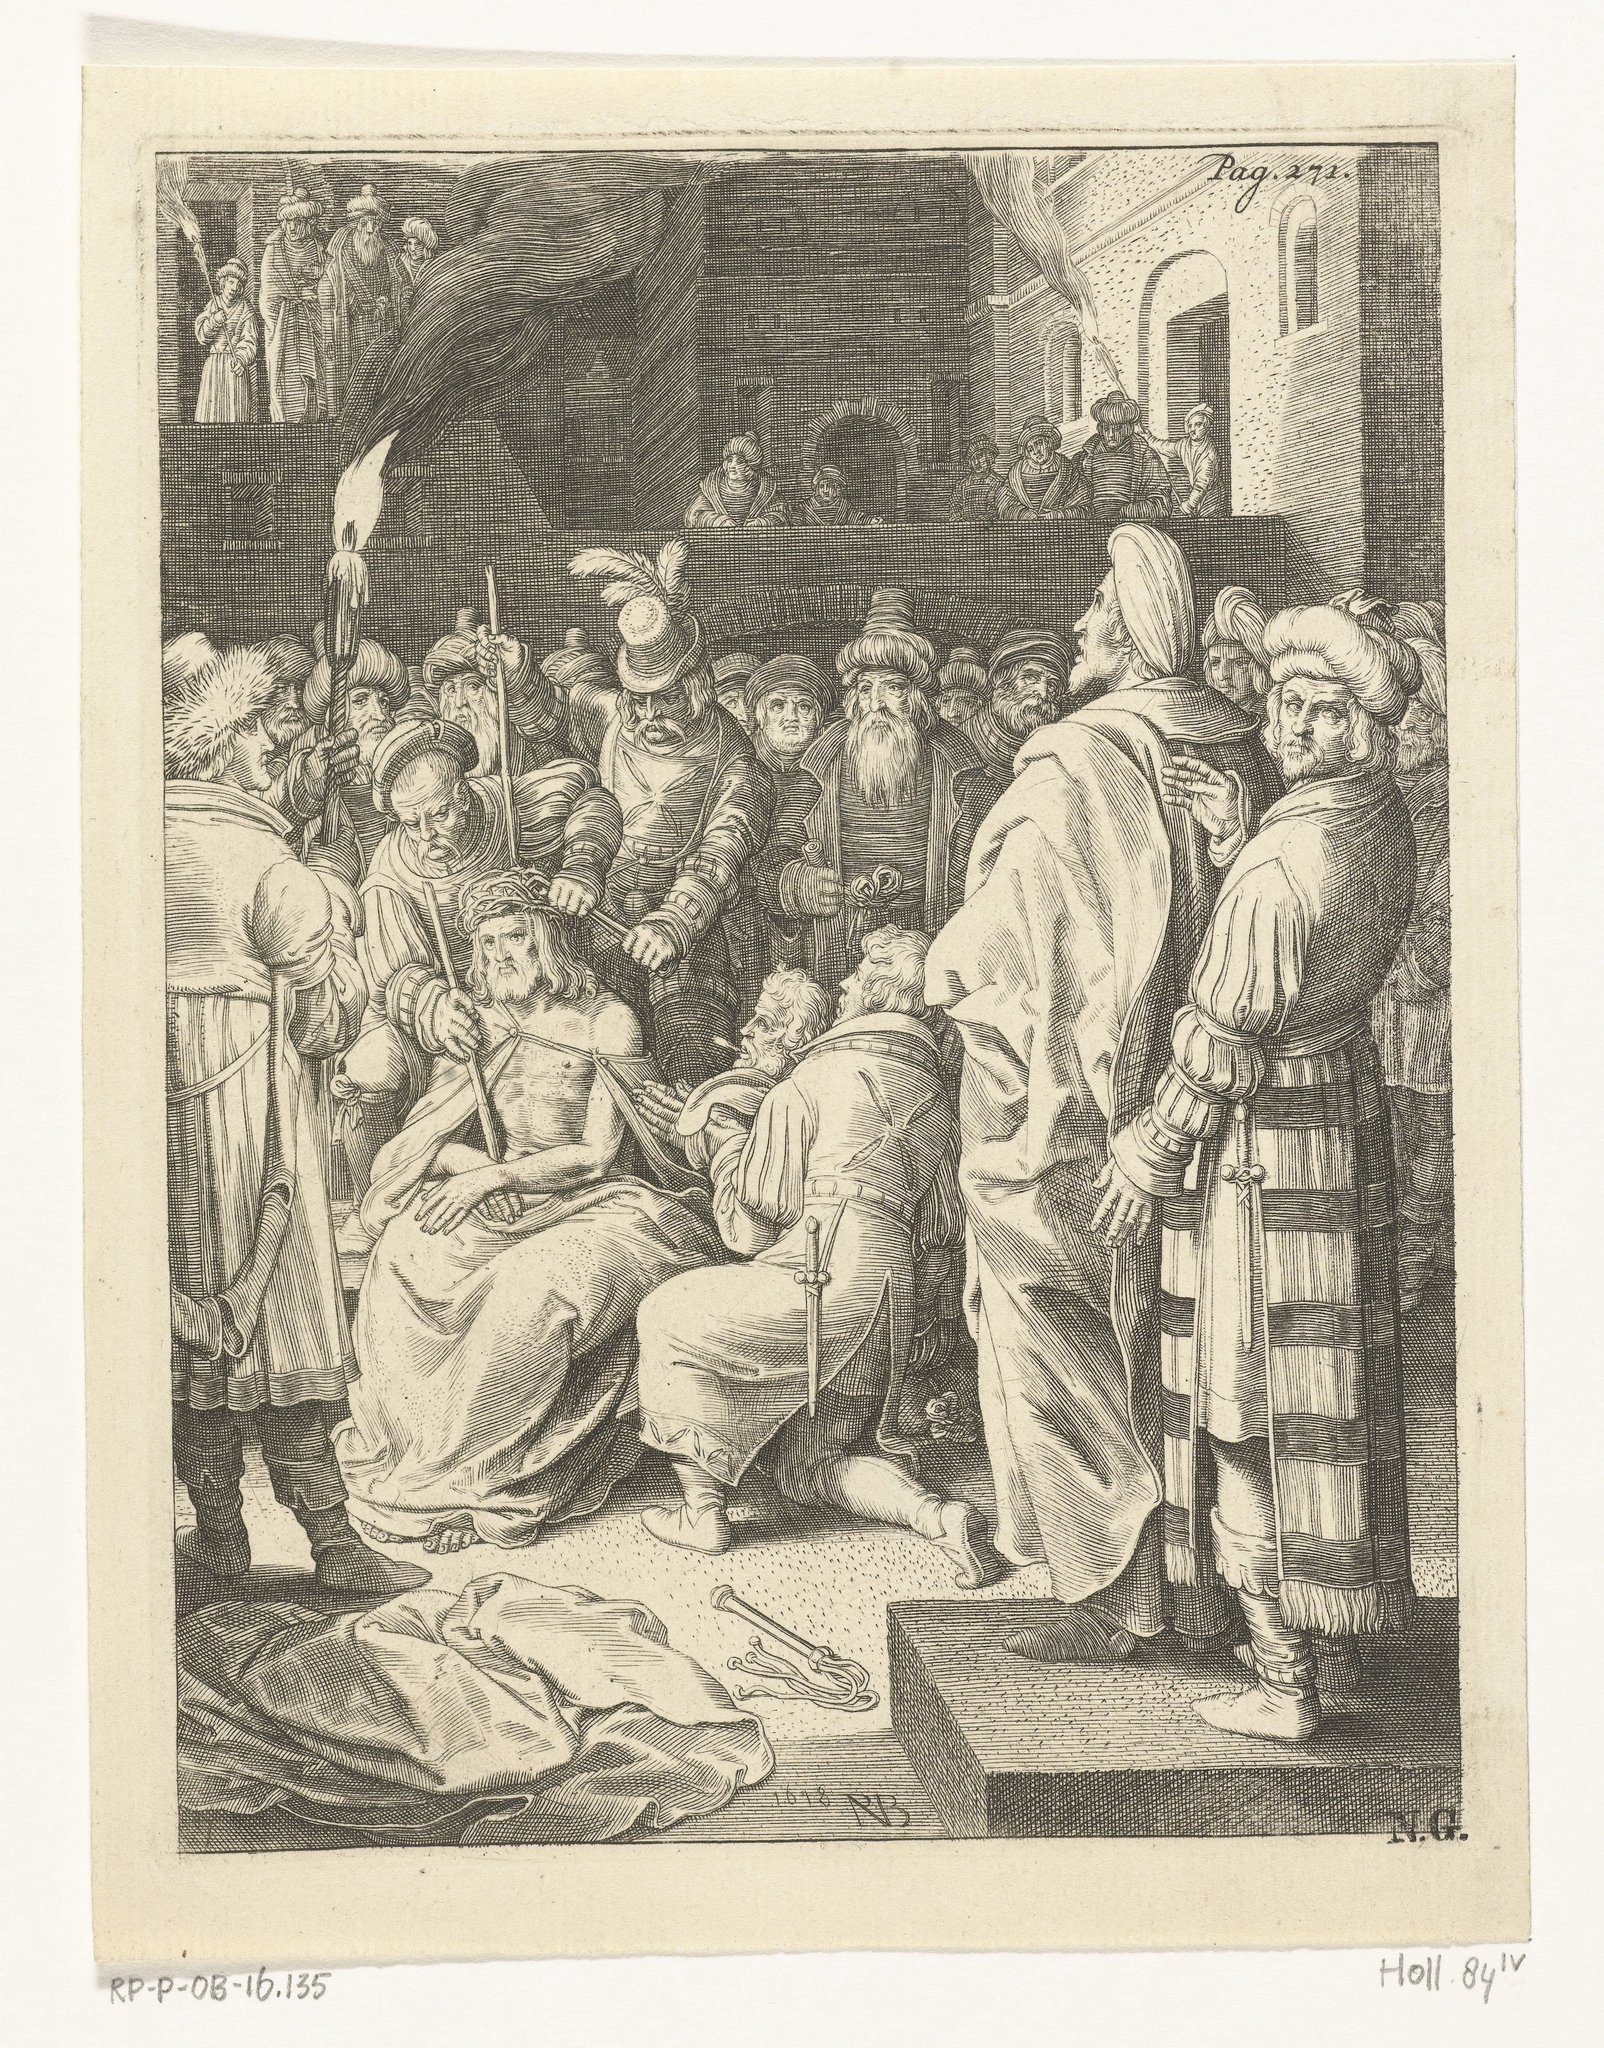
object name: print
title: De Passie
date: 1618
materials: paper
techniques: engraving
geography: netherlands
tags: the crowning with thorns: soldiers with sticks place a thorny crown on christ's head and give him a reed (matthew 27:27-31; mark 15:16-20; john 19:2-3)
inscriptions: collector's mark: Lugt 2228, inscription: ‘Pag. 271’, collector's mark: Lugt 1967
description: Christus zit tussen soldaten op het plein van het gerechtsgebouw van Pilatus. Hij draagt een mantel en krijgt een stok als scepter in zijn hand, soldaten drukken de doornenkroon op zijn hoofd en omstanders reageren spottend door voor hem te knielen.